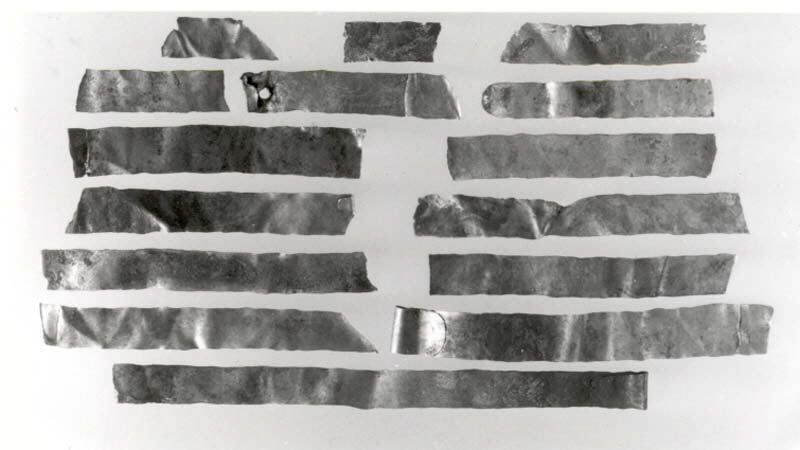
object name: hair ribbon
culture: sumerian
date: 2600-2500 BCE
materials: gold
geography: mesopotamia